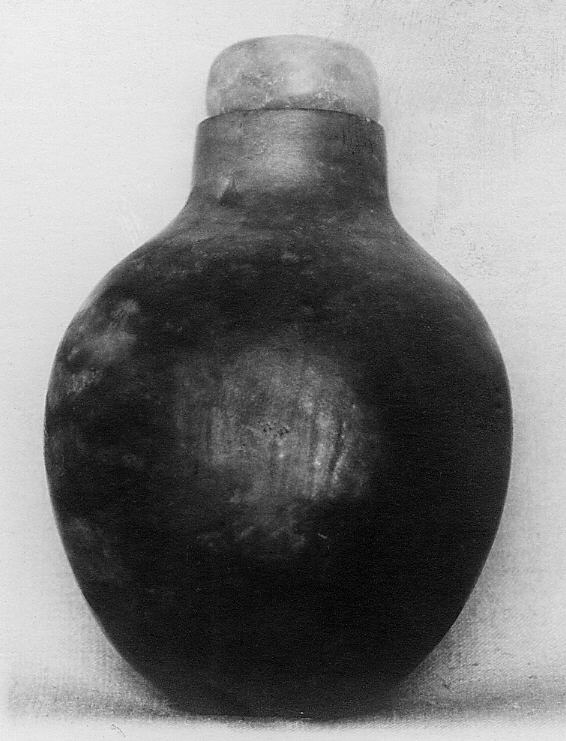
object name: snuff bottle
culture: chinese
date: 1801-1900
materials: jade